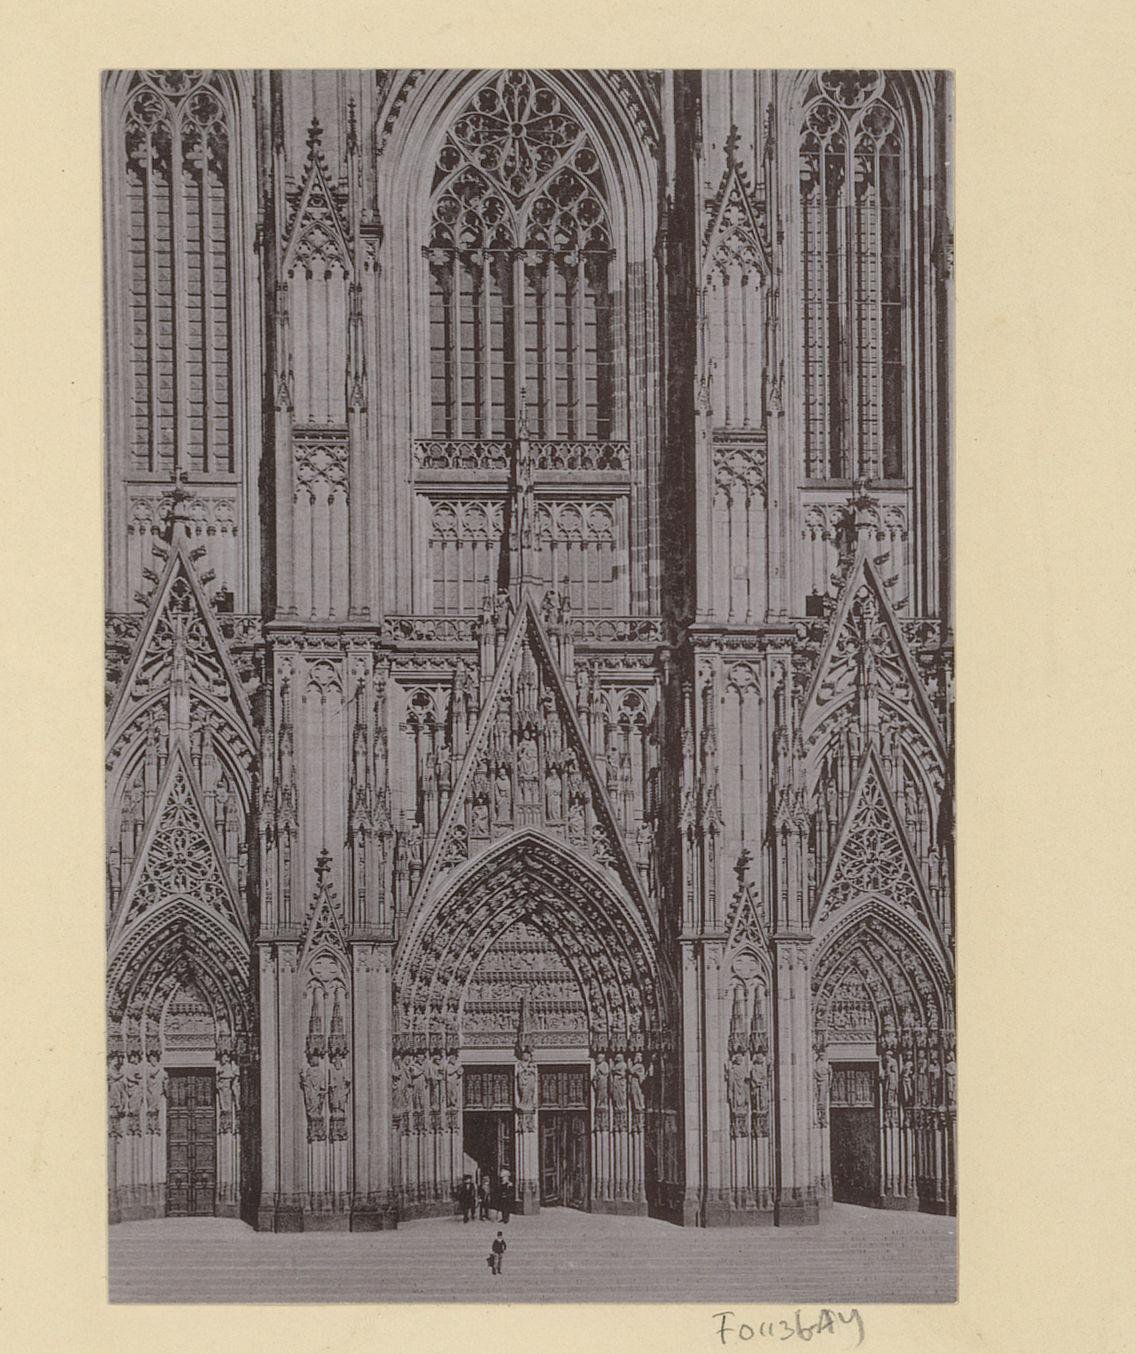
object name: photomechanical print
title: Portaal van de Dom van Keulen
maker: Anonymous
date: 1880-1895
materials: paper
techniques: photograph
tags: parts of church exterior and annexes: portal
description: Onderdeel van Fotoalbum met opnames van bezienswaardigheden in België, Duitsland en Noorwegen.